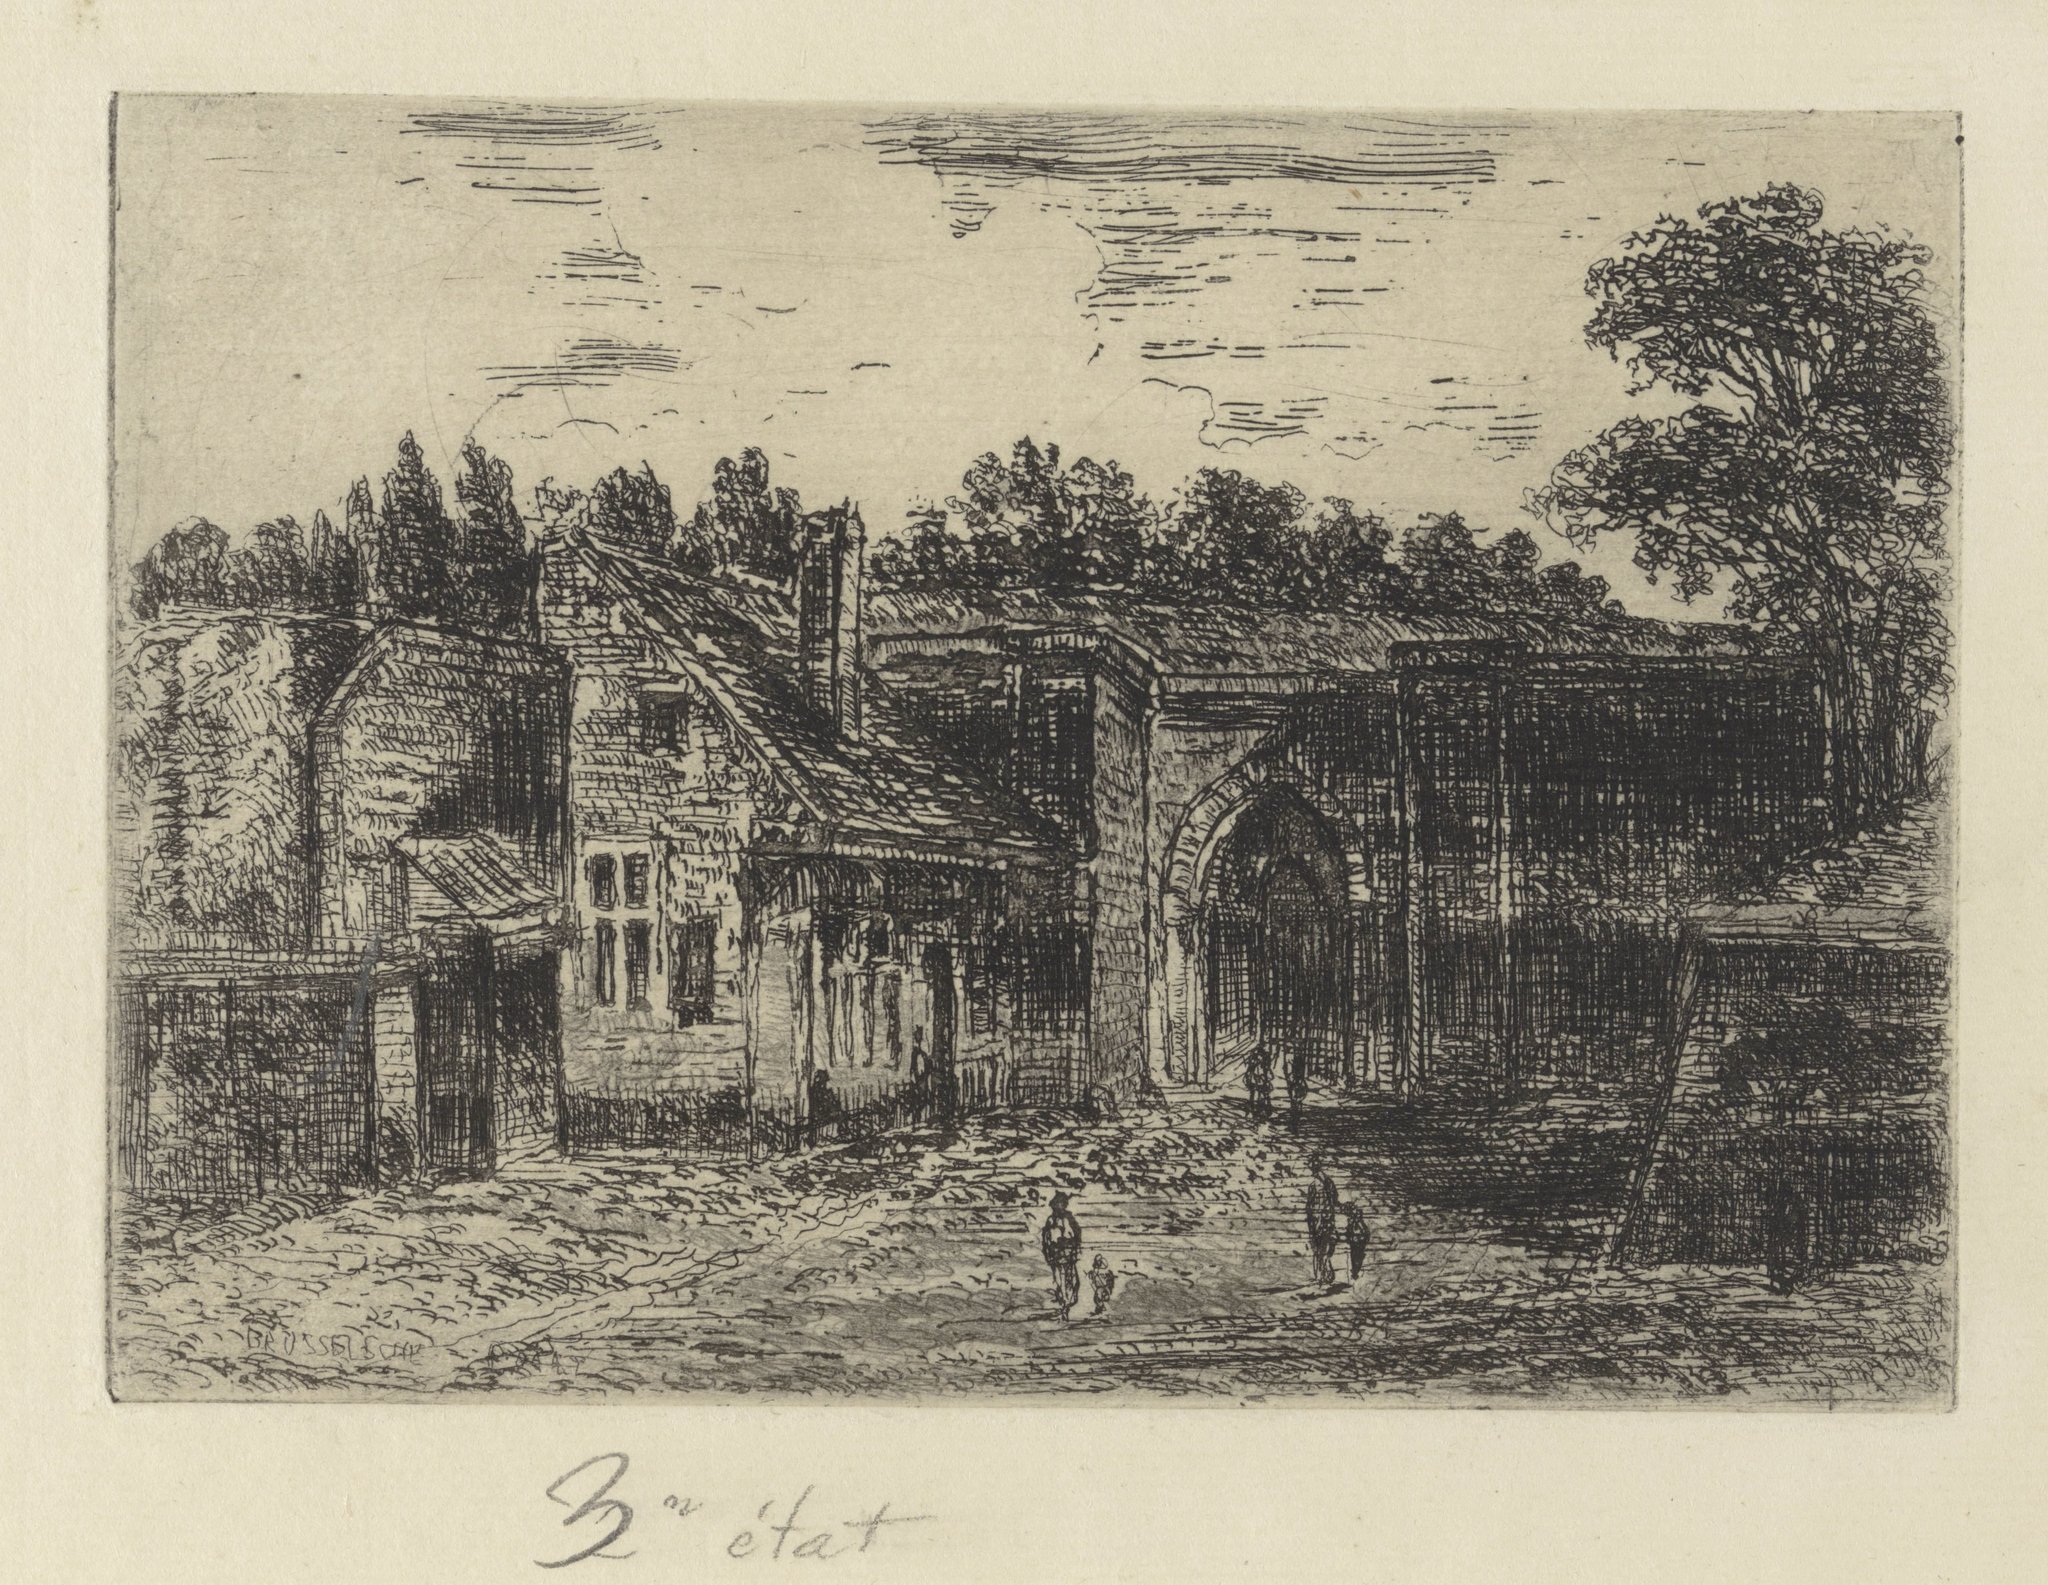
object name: print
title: Brusselsche Poort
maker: alexander schaepkens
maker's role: draughtsman, print maker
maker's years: 1815-1899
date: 1830-1899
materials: paper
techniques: etching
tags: street, maastricht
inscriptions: collector's mark: Lugt 2228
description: Veldzijde van de Brusselse Poort, links het buitenwachthuis.